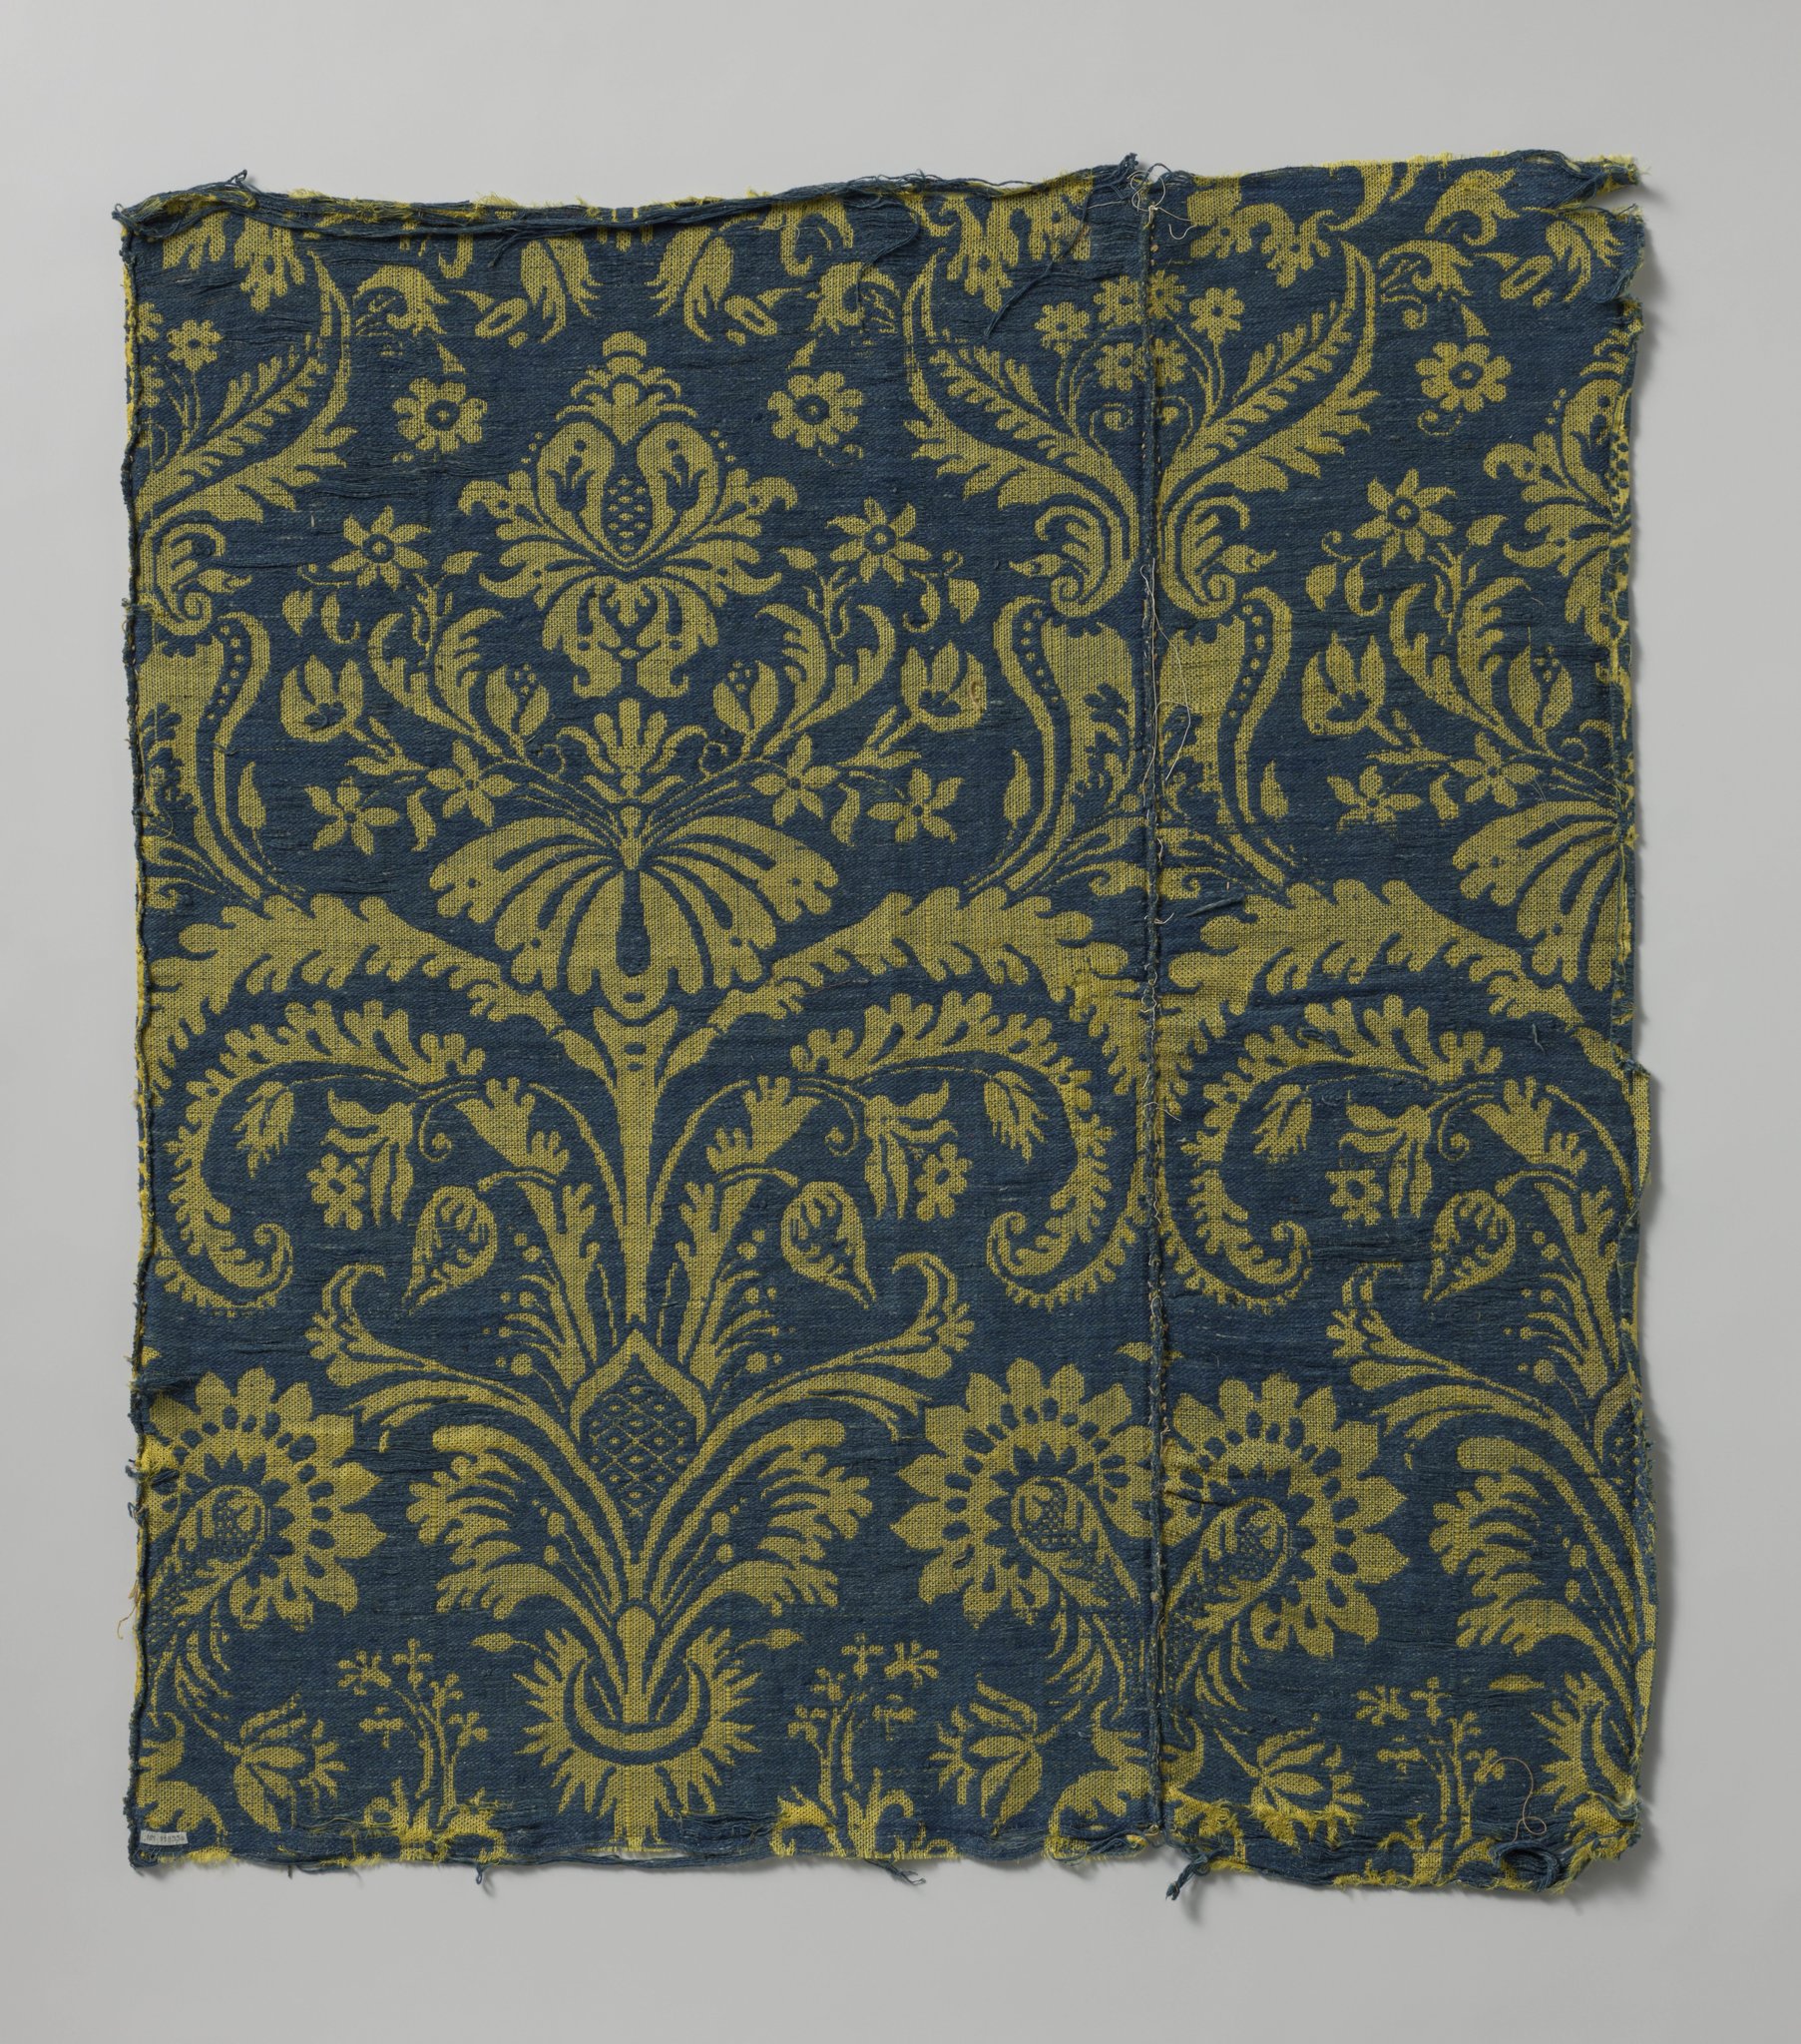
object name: fragment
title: Fragment geel en blauwe zijdeweefsel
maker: Anonymous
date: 1600-1699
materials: cotton, silk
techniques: lampas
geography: italy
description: Twee aan elkaar gezette fragmenten van half zijden weefsel. Het patroon van blauw is een symetrisch renaissance ornament, gestileerde ranken, bloemen en bladen op een fond van flottante geel zijden draden.